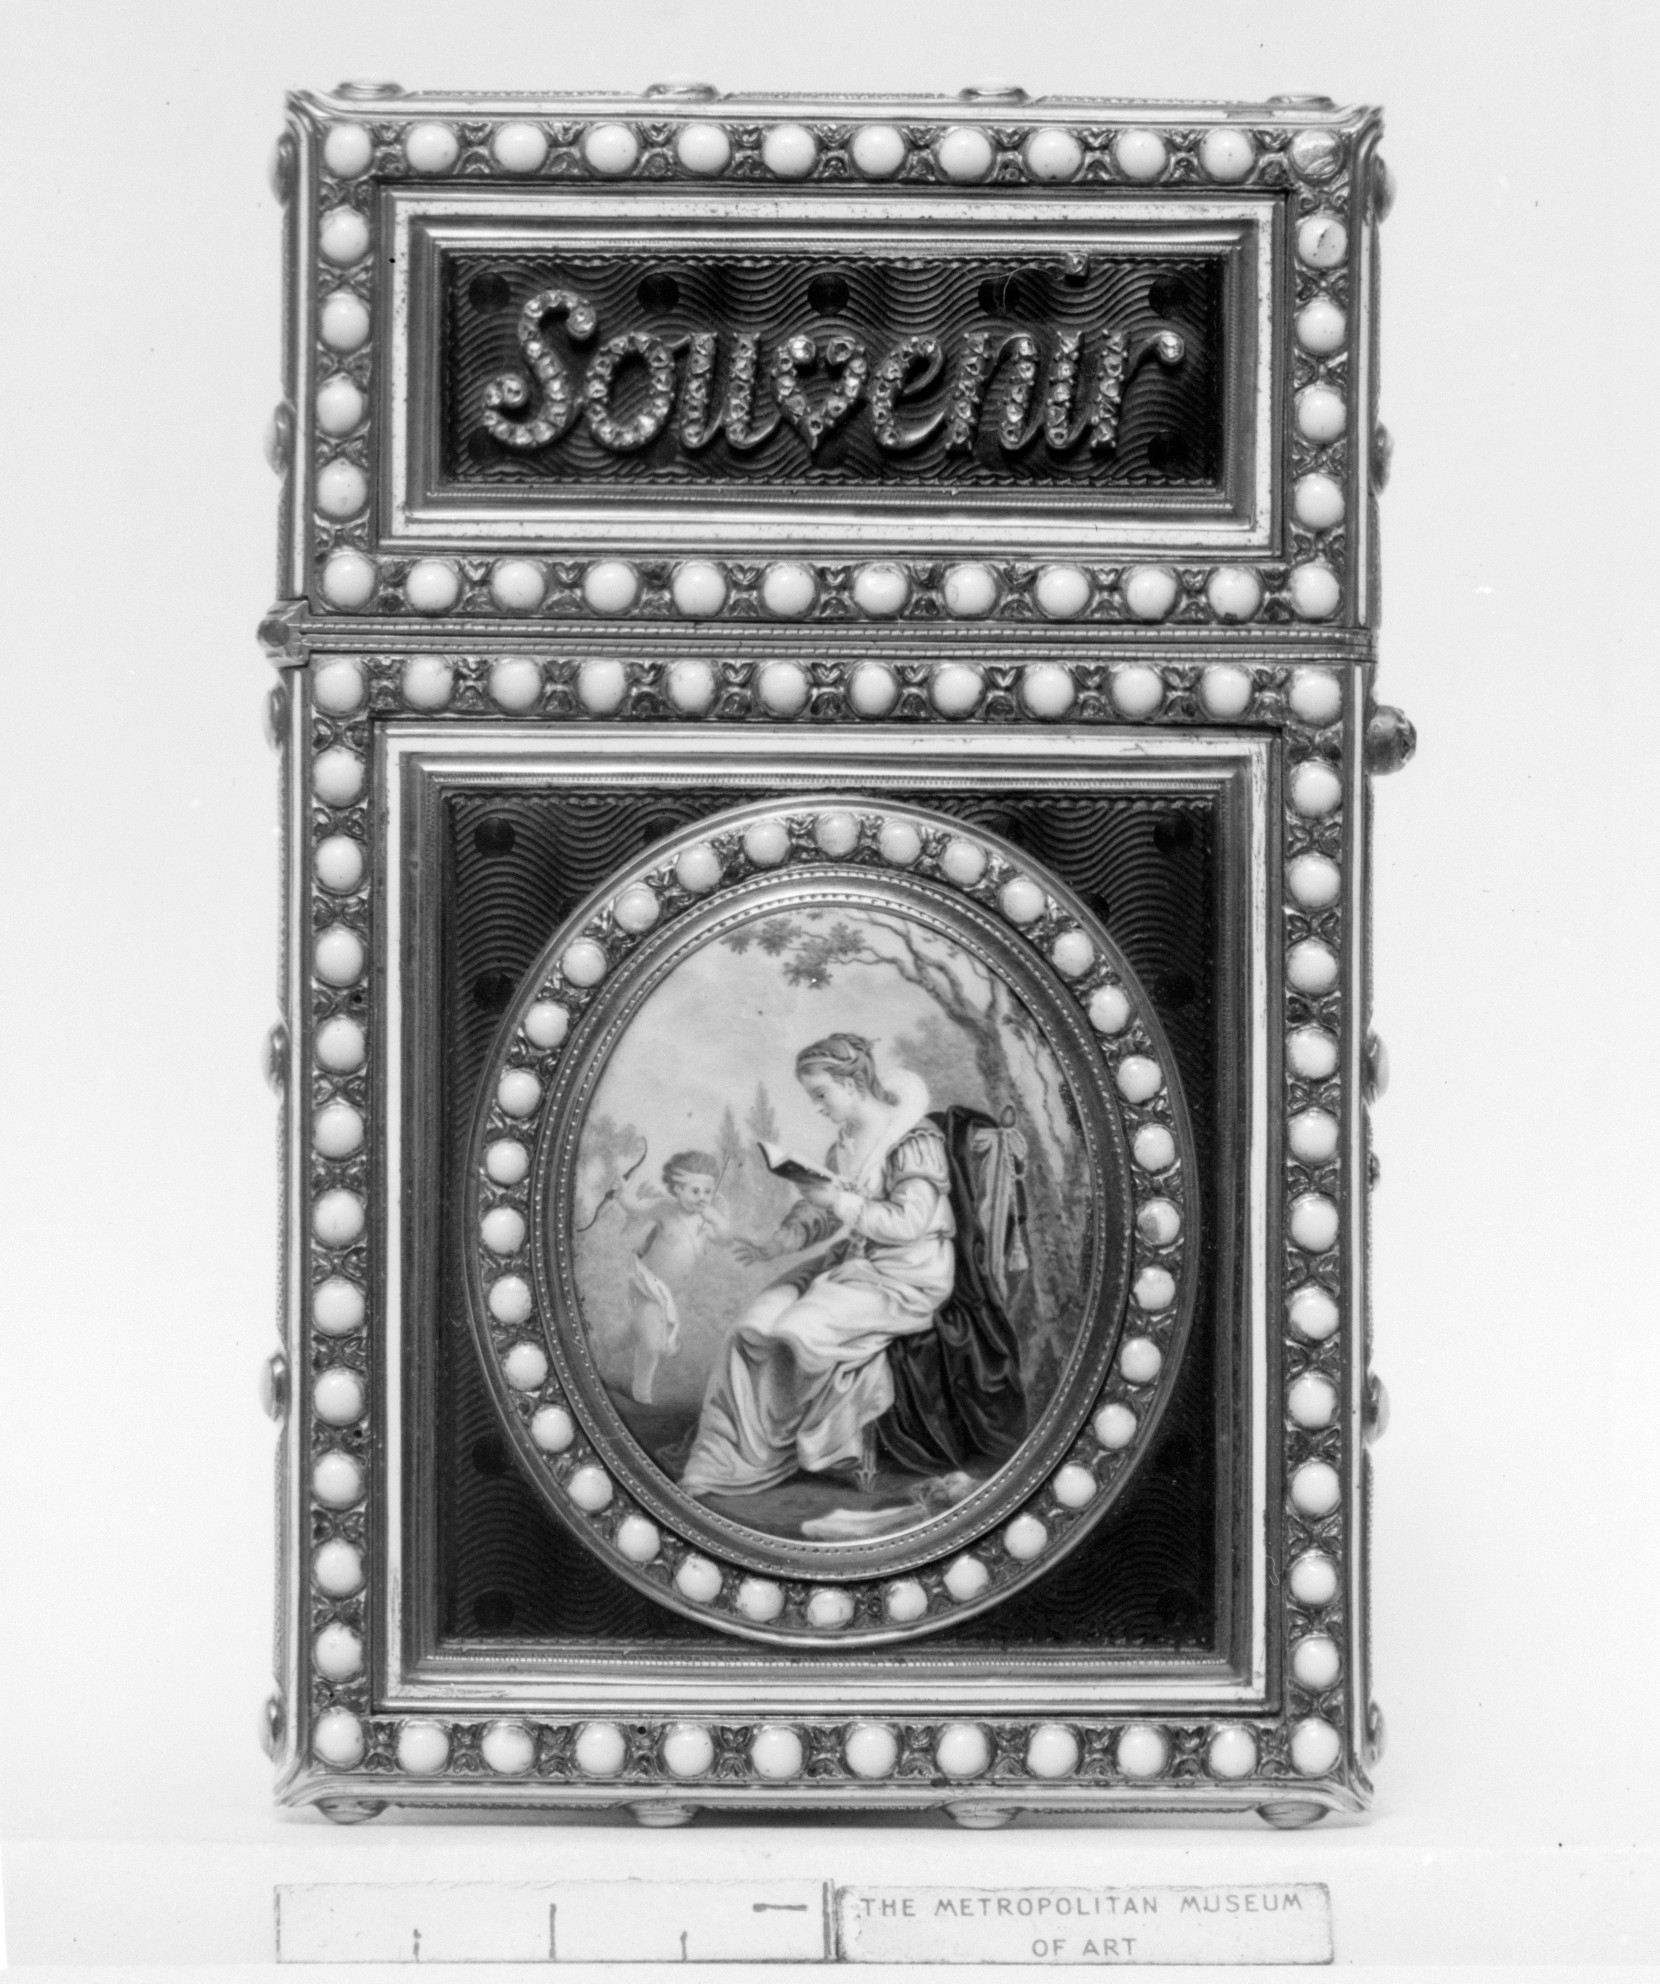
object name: souvenir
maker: joseph etienne blerzy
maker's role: maker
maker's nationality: french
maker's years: 1750-1806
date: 1781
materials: diamond, enamel, gold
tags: women,reading,cupid